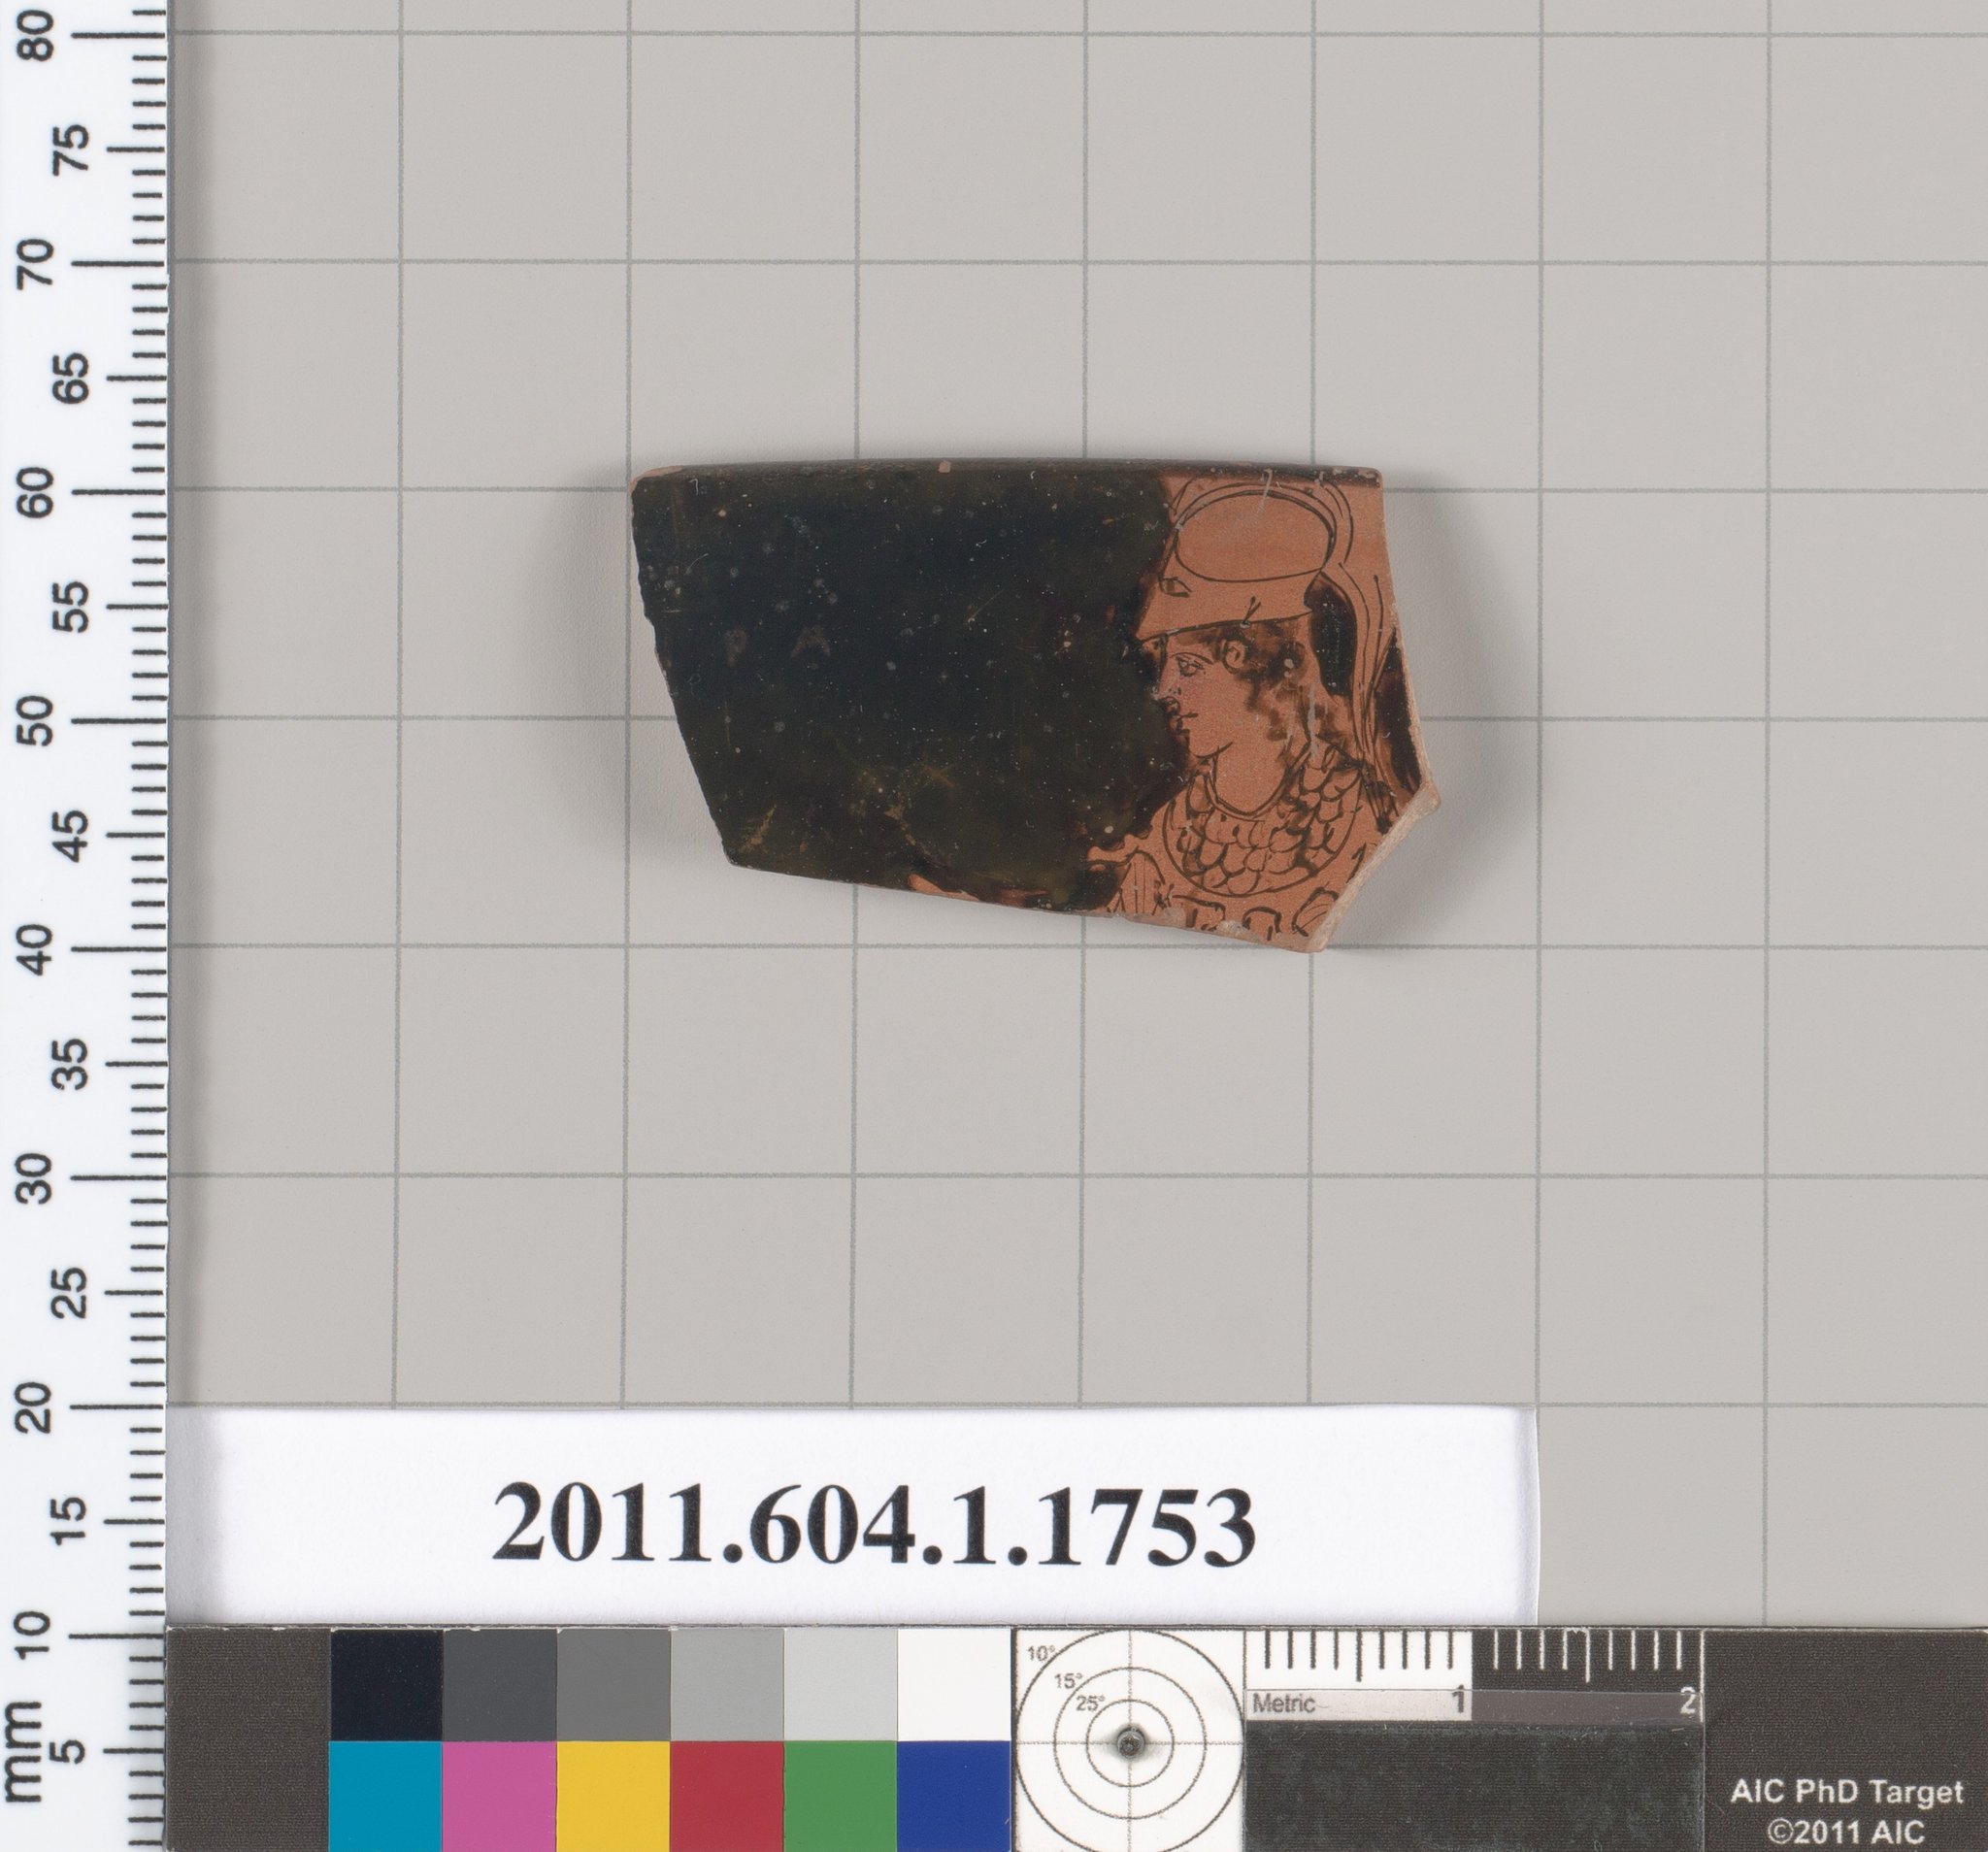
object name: kylix fragment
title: Terracotta rim fragment of a kylix (drinking cup)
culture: greek, attic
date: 467-435 BCE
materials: terracotta